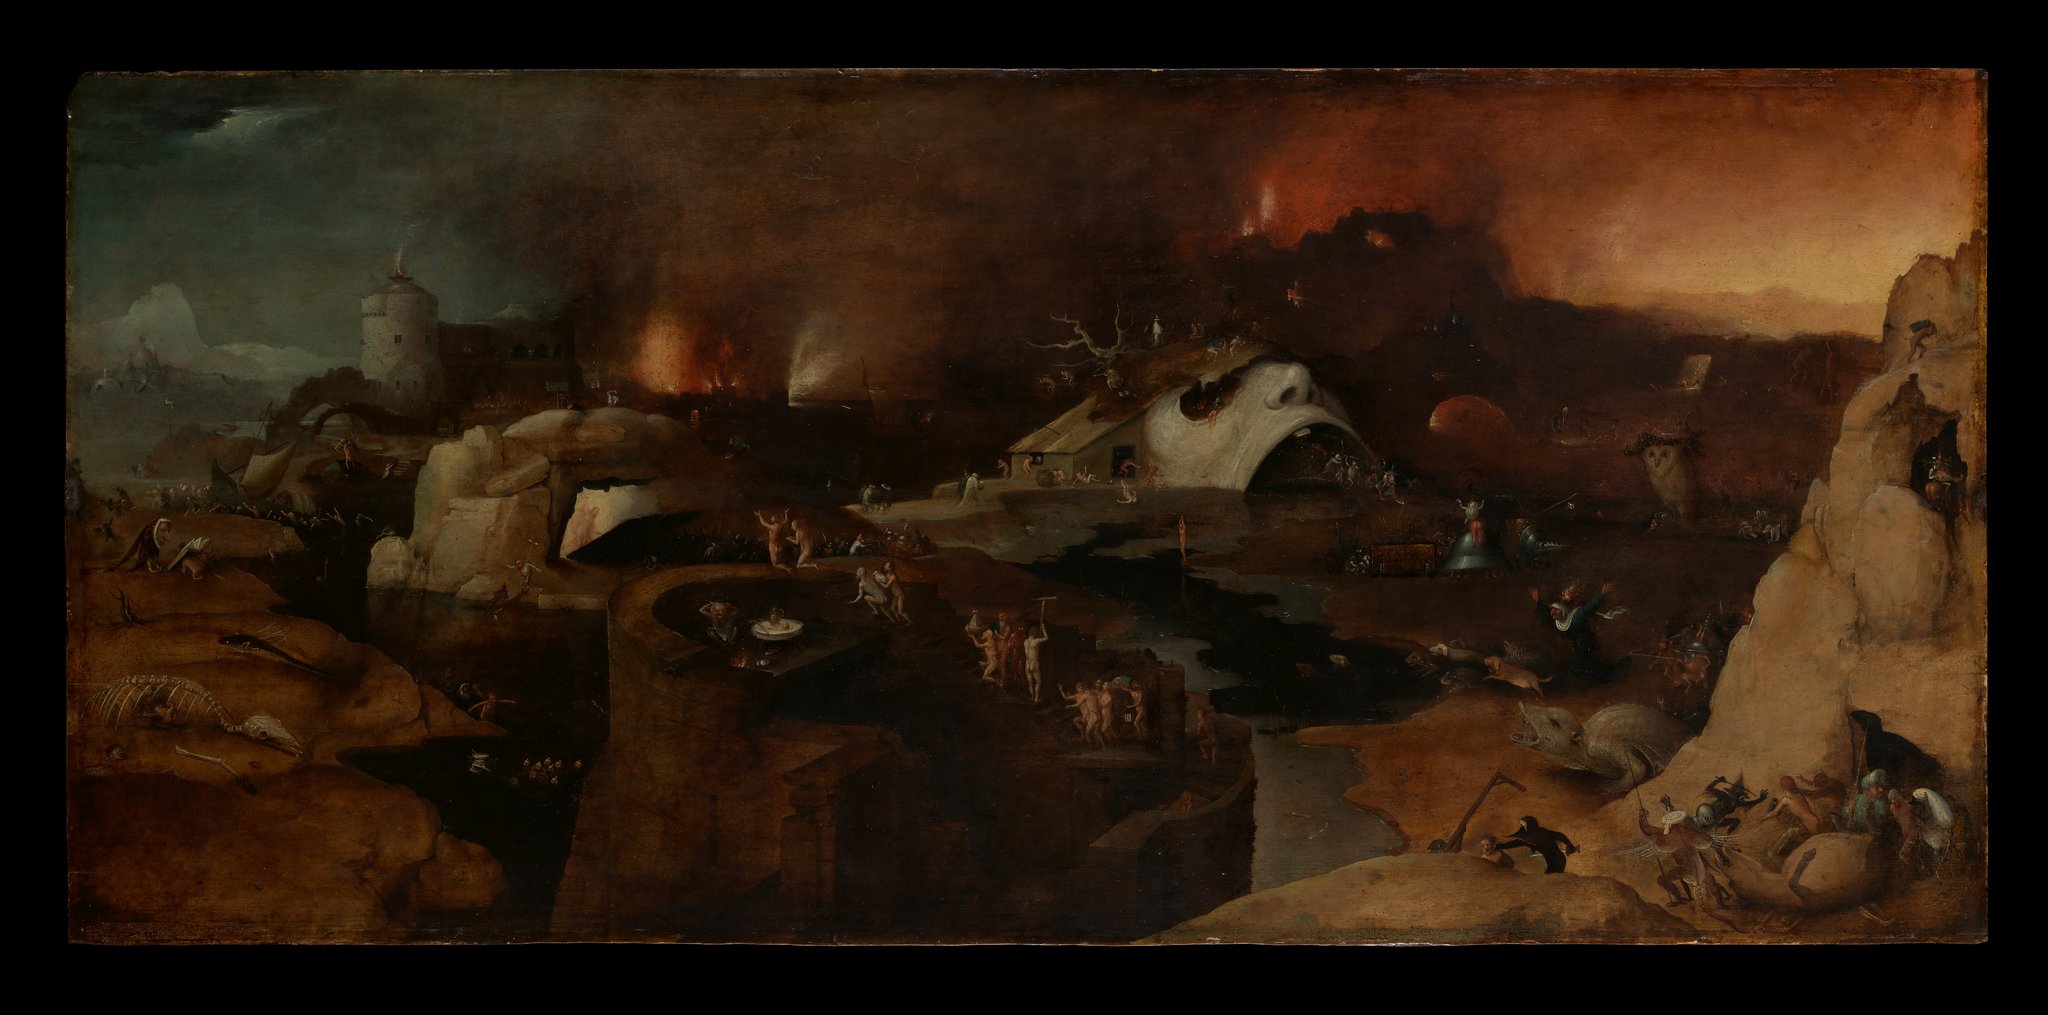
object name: painting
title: Christ's Descent into Hell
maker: hieronymus bosch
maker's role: artist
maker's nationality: netherlandish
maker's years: 1450-1516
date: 1550-1560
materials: oil, wood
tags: owls,fire,christ,hell